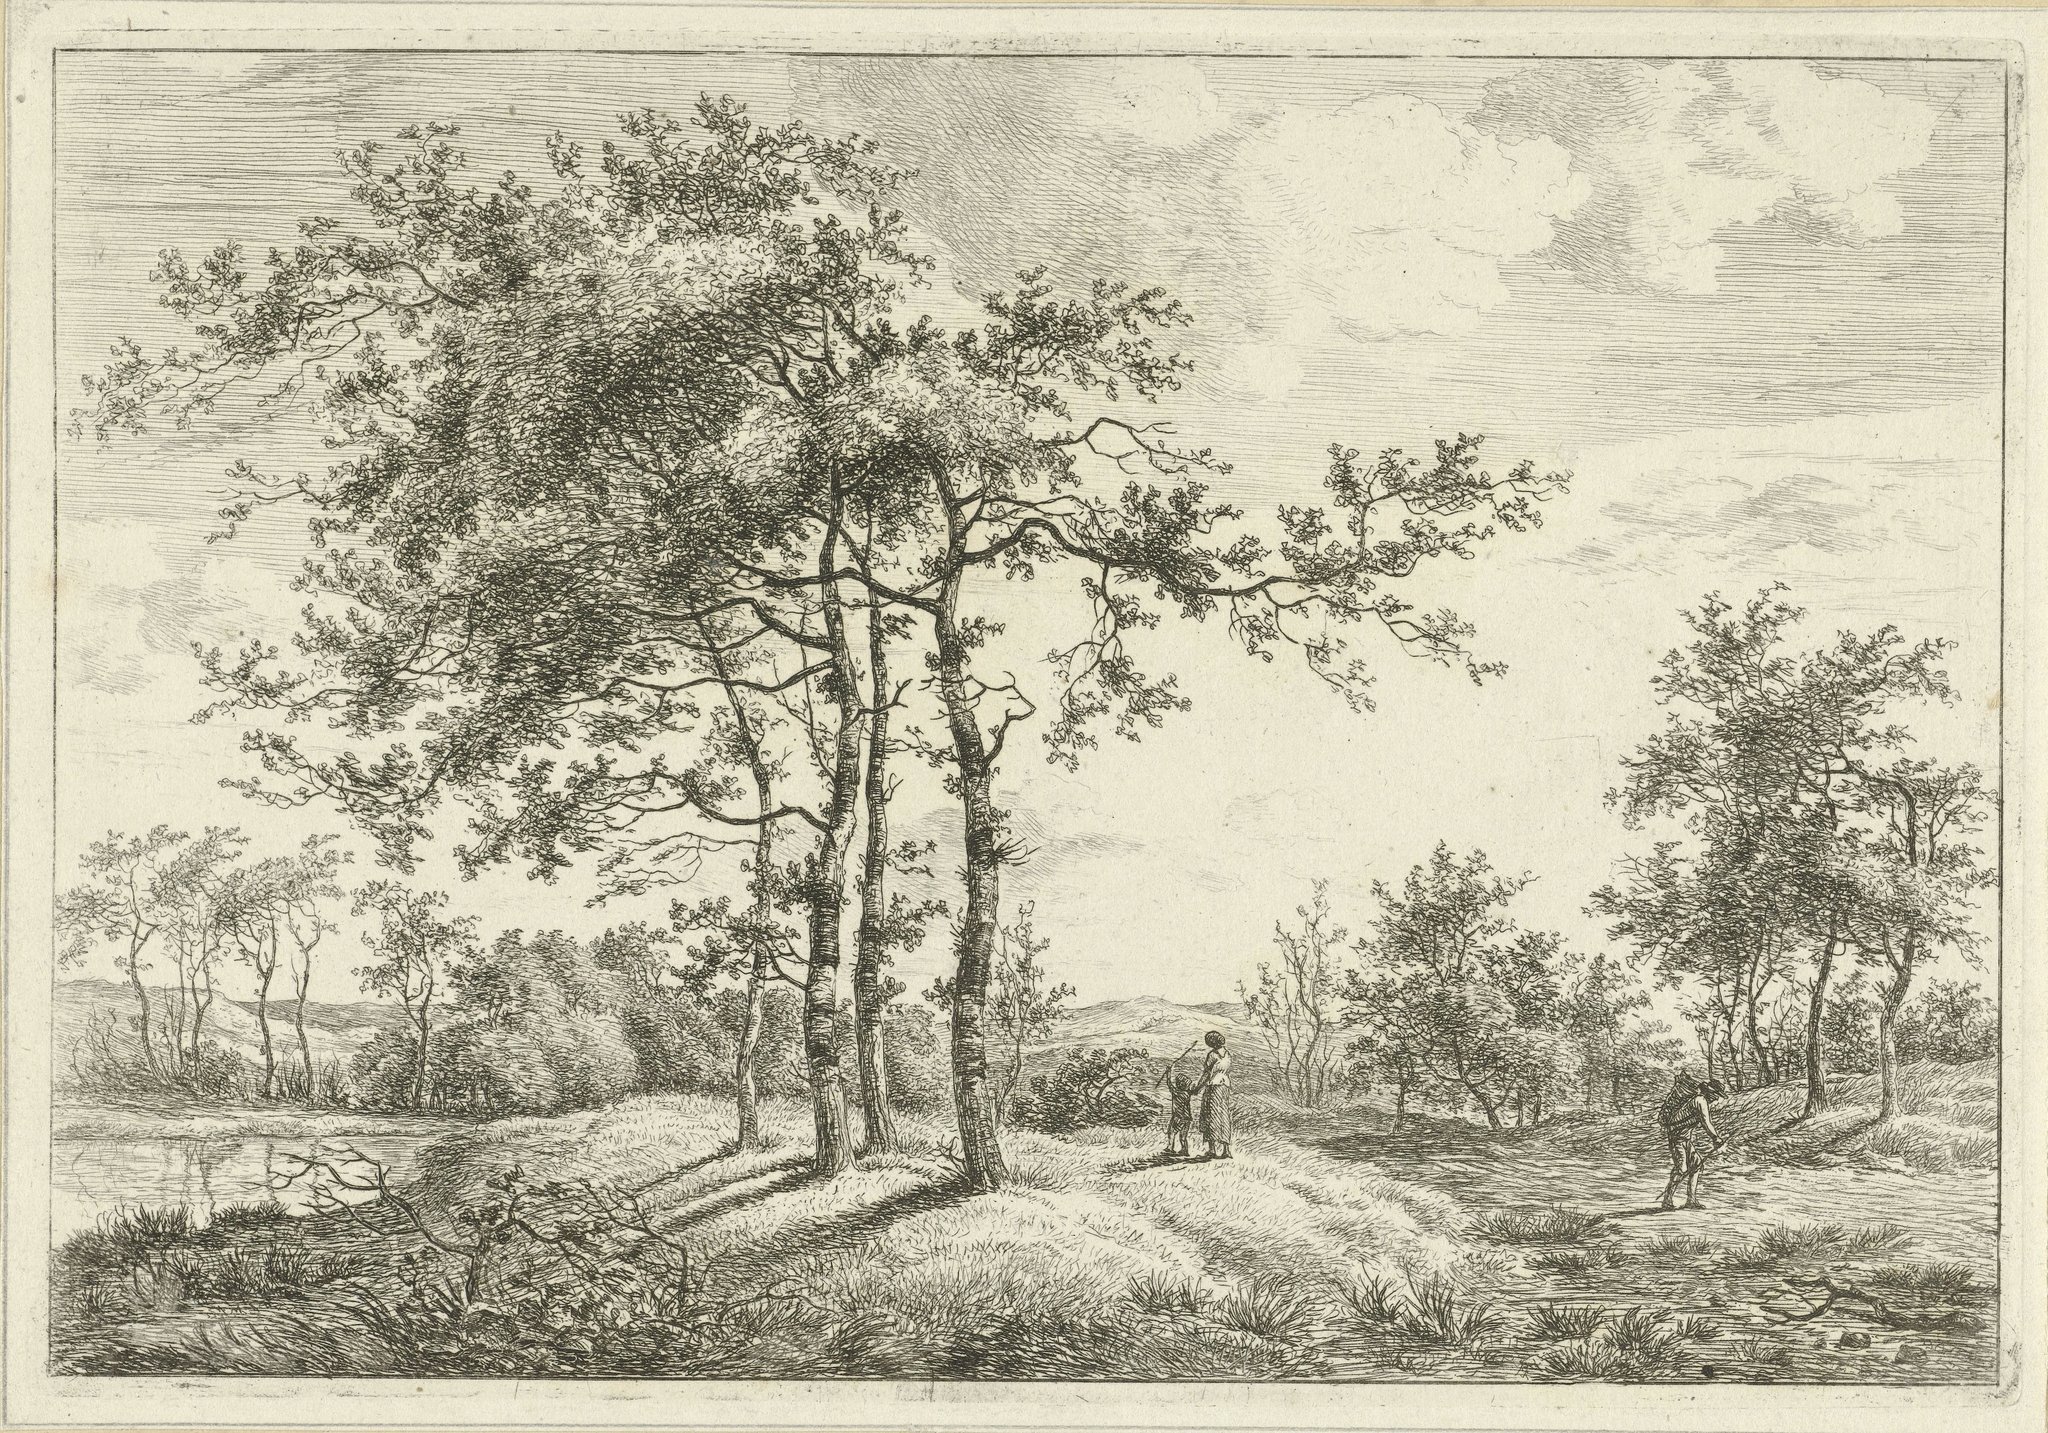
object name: print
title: Landschap met moeder en kind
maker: hermanus fock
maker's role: conservator, draughtsman, painter, print maker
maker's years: 1766-1822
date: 1781-1822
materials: paper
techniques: etching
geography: amsterdam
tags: landscapes, carrying something in basket, bag, rucksack, etc.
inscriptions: collector's mark: Lugt 2228, collector's mark: Lugt 924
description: In een landschap met hoge bomen staan een vrouw en een kind in het gras. Op het pad loopt een man met een mand op zijn rug.